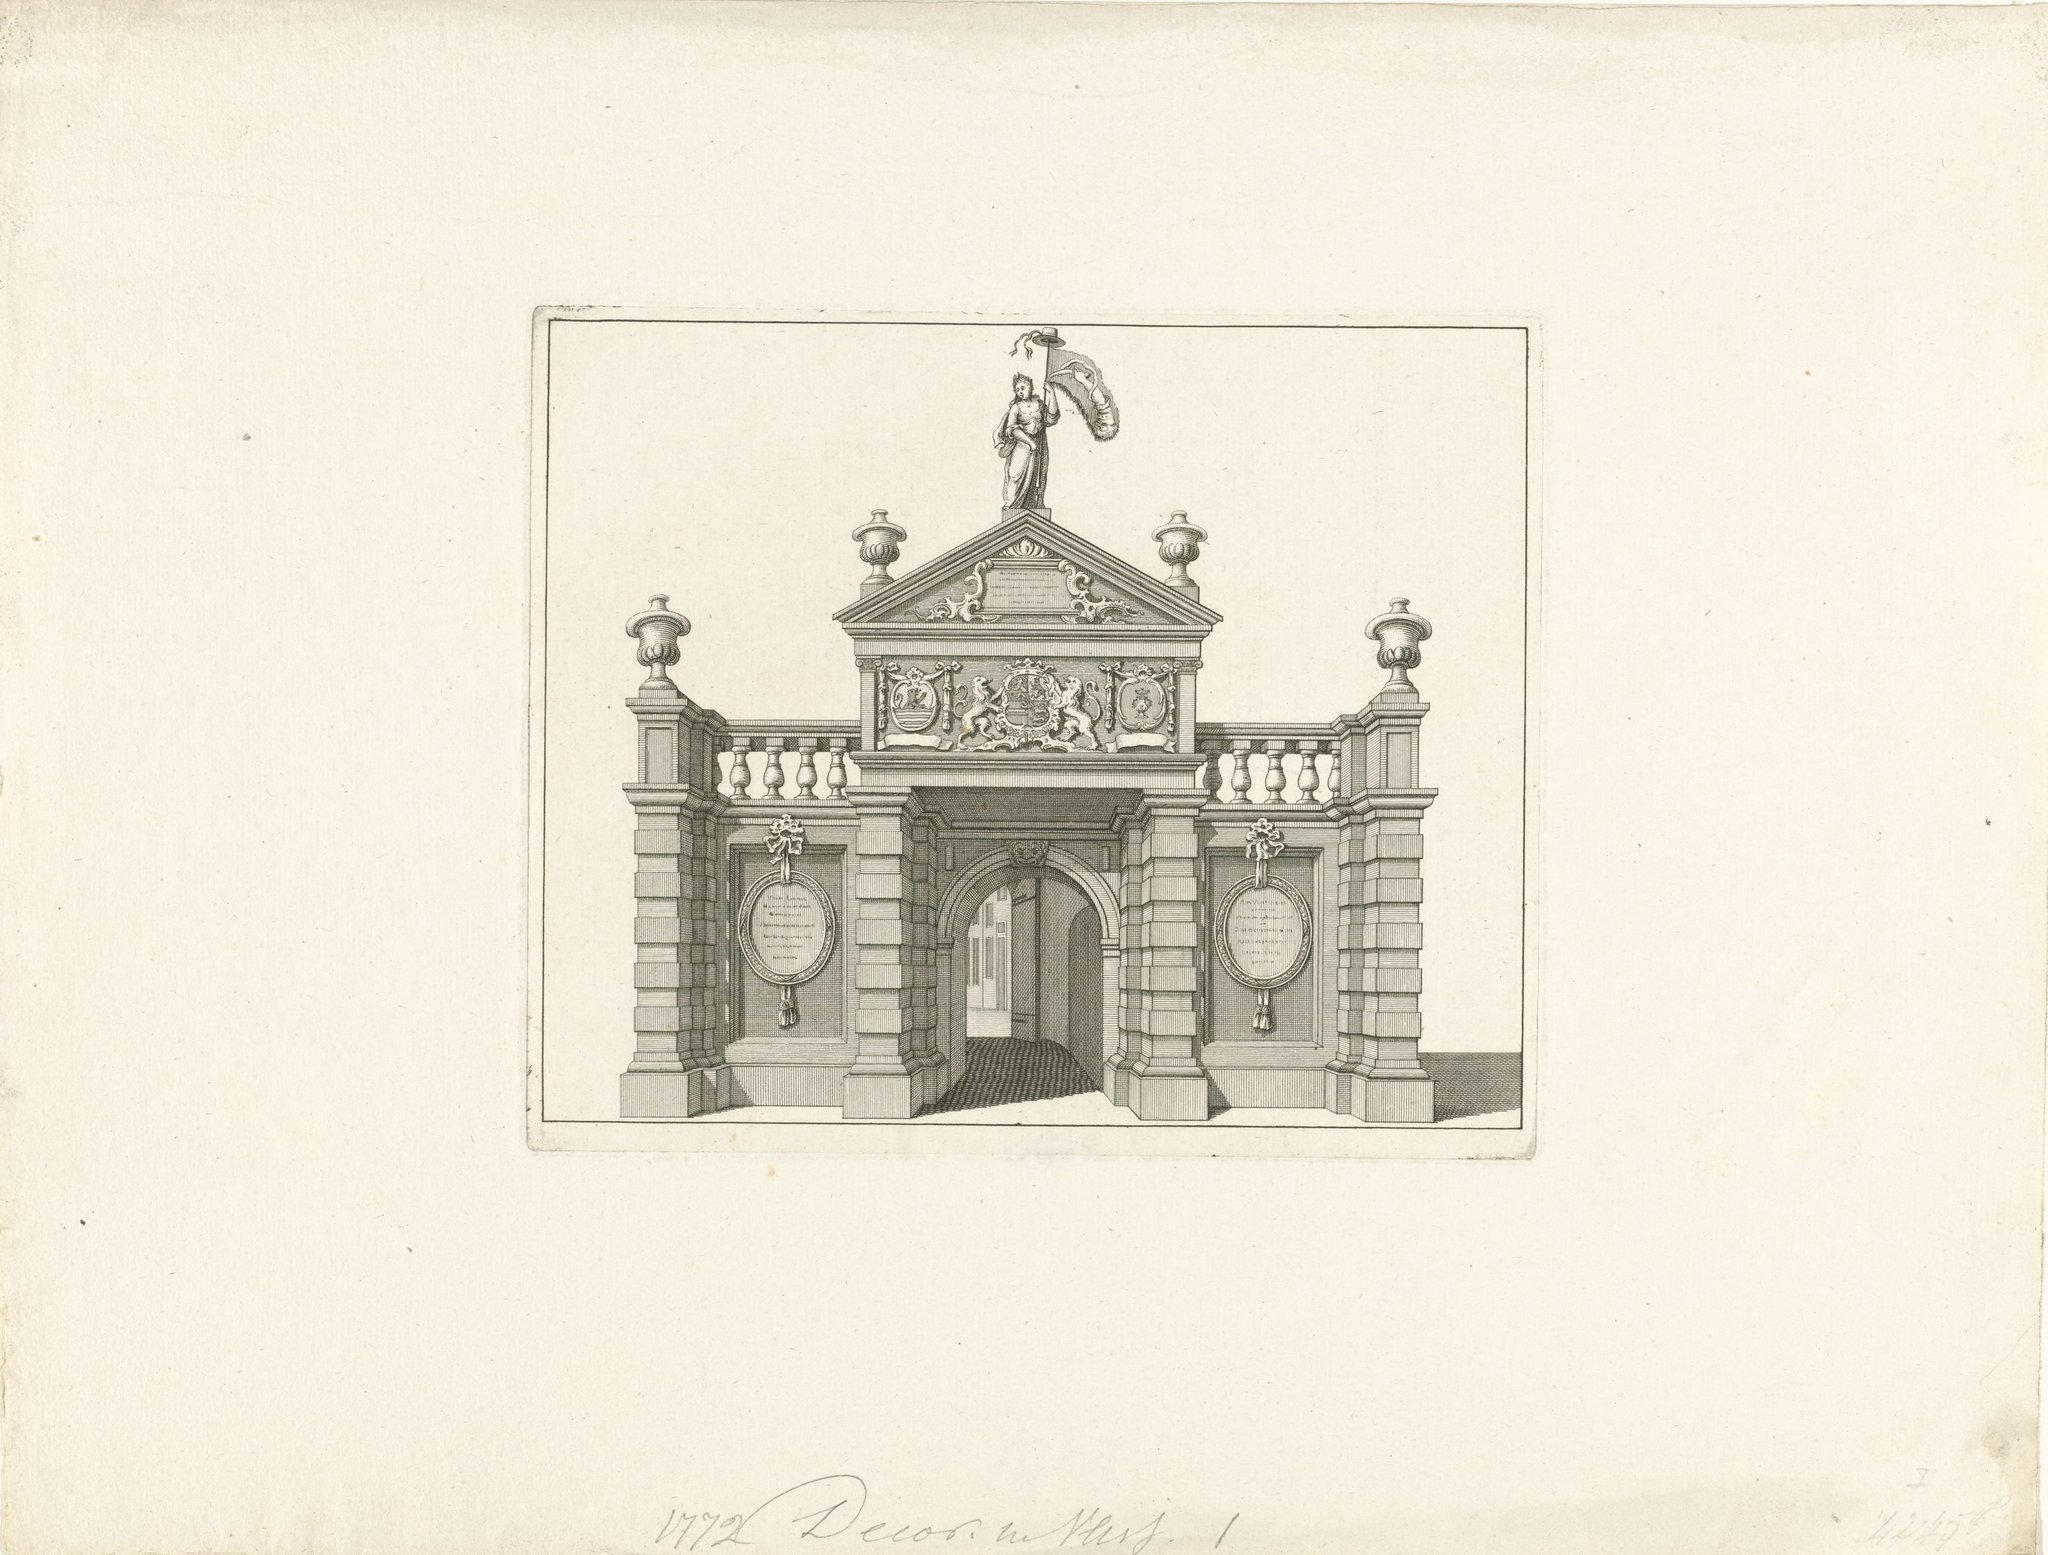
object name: print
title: De Middelburgse Poort te Vlissingen, 1772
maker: caspar jacobsz. philips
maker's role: draughtsman, print maker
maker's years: 1732-1789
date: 1772-1773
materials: paper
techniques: engraving, etching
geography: northern netherlands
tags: triumphal arch, flushing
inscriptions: collector's mark: Lugt 2228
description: De Middelburgse Poort te Vlissingen, erepoort opgericht namens de stad Middelburg bij de viering van 200 jaar vrijheid in Vlissingen, 6 april 1772. Onderdeel van een groep van negen platen genummerd I-X van de decoraties bij dit feest.